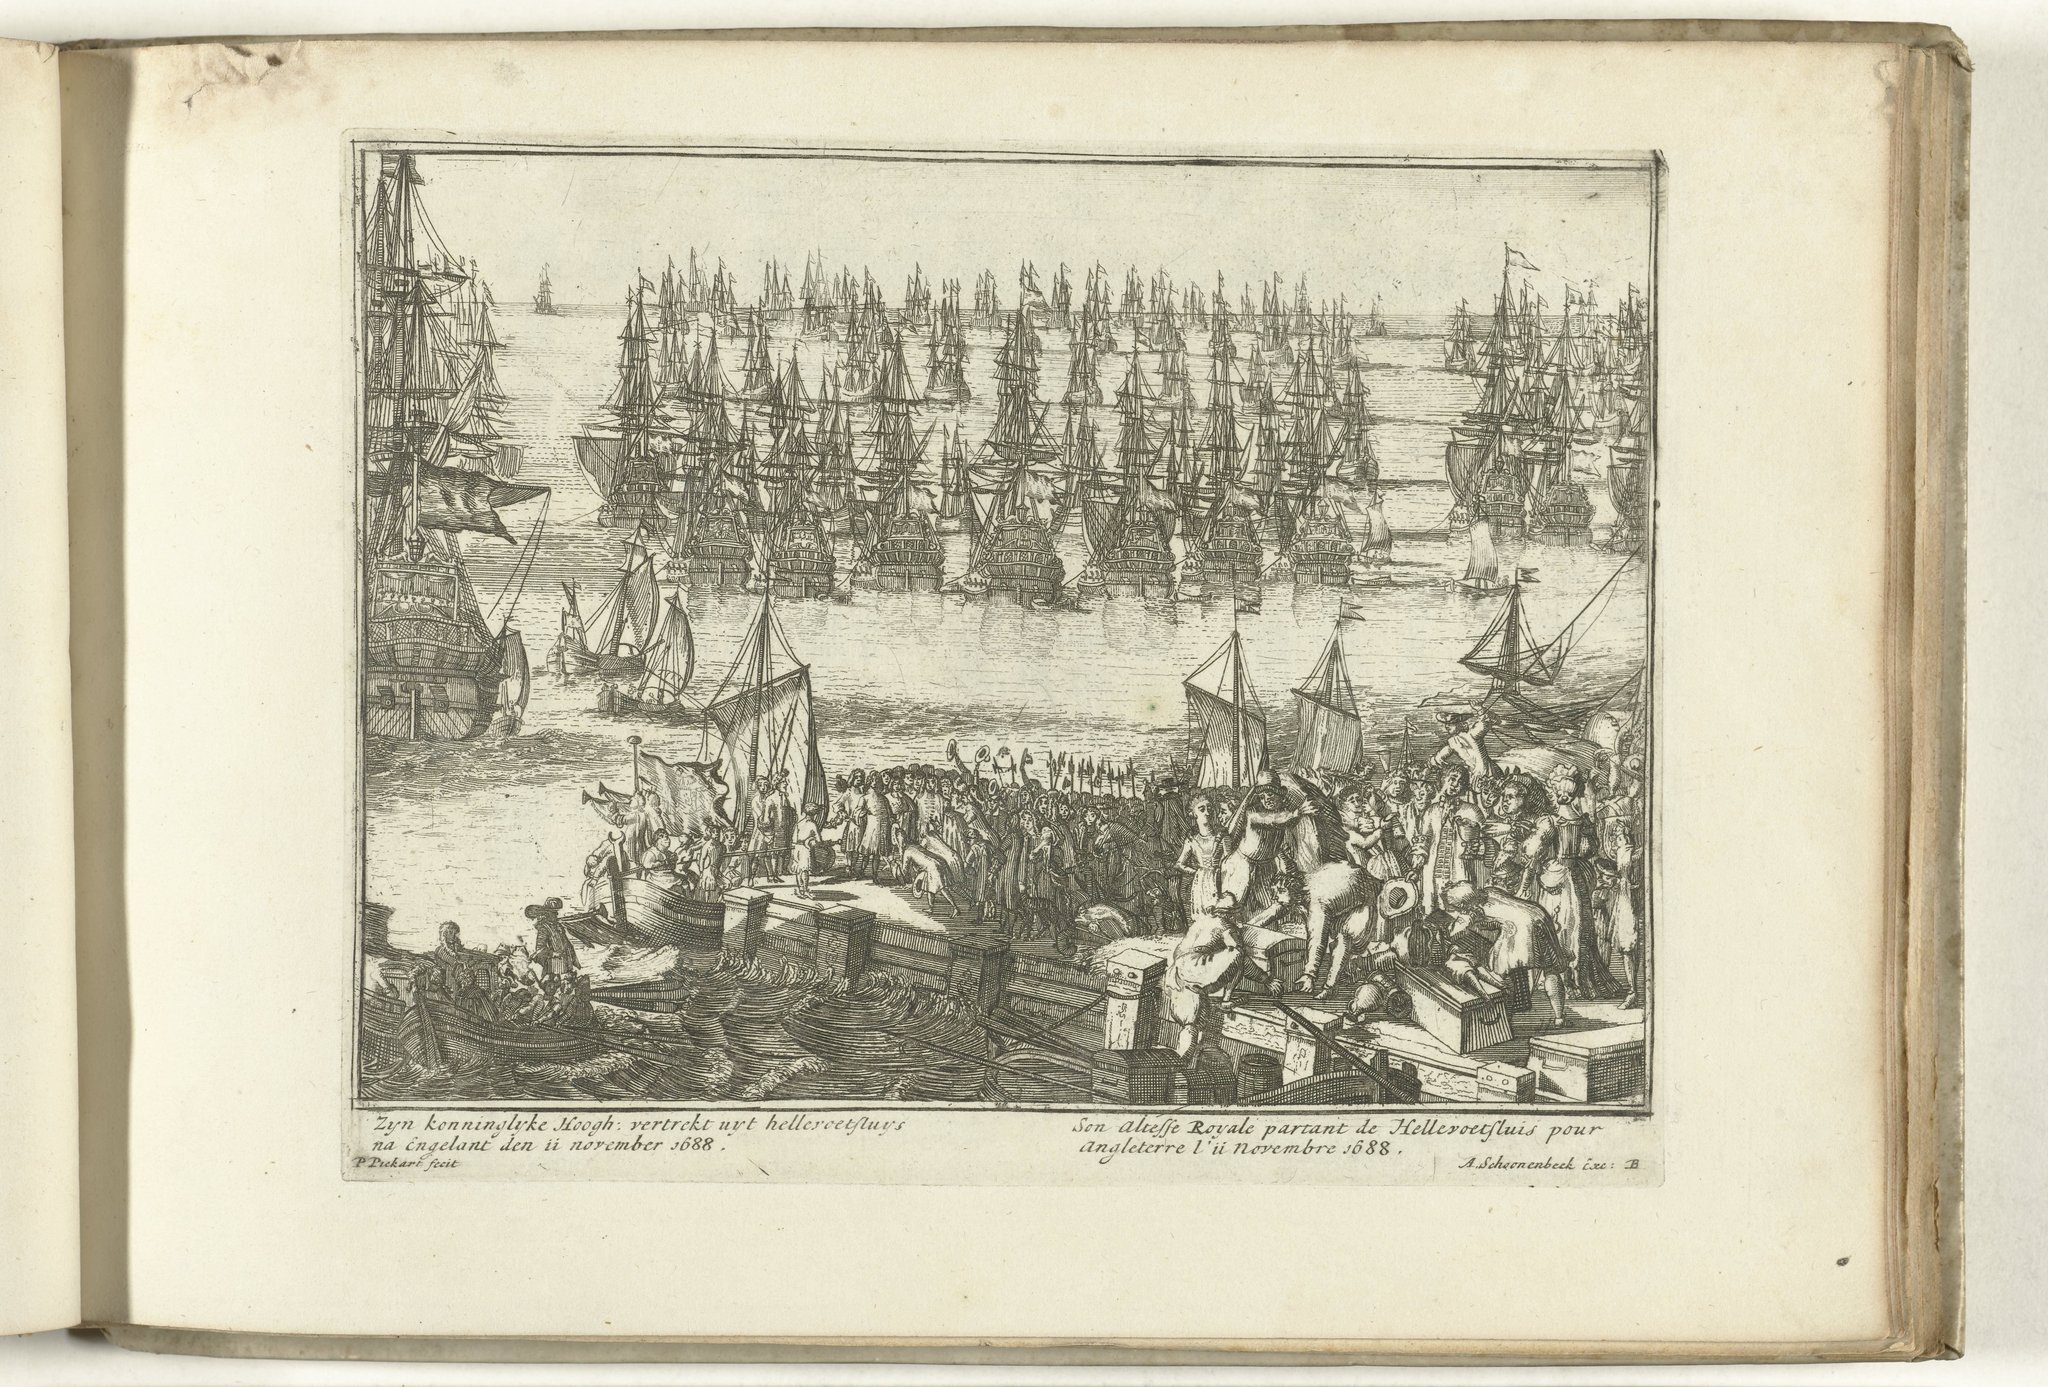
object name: print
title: Zyn konninglyke Hoogh: vertrekt uyt hellevoetsluys na Engelant den 11 november 1688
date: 1689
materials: paper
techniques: etching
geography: amsterdam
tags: william iii (prince of orange and king of england, scotland, and ireland), departure ~ travelling, hellevoetsluis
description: Prins Willem III vertrekt met de vloot vanuit Hellevoetsluis naar Engeland, 11 november 1688. De prins neemt op de pier afscheid. Plaat B in de serie 'Engelants schouwtoneel' over de Glorious Revolution 1688-1689 (tweede deel). Met onderschriften in het Nederlands en Frans.